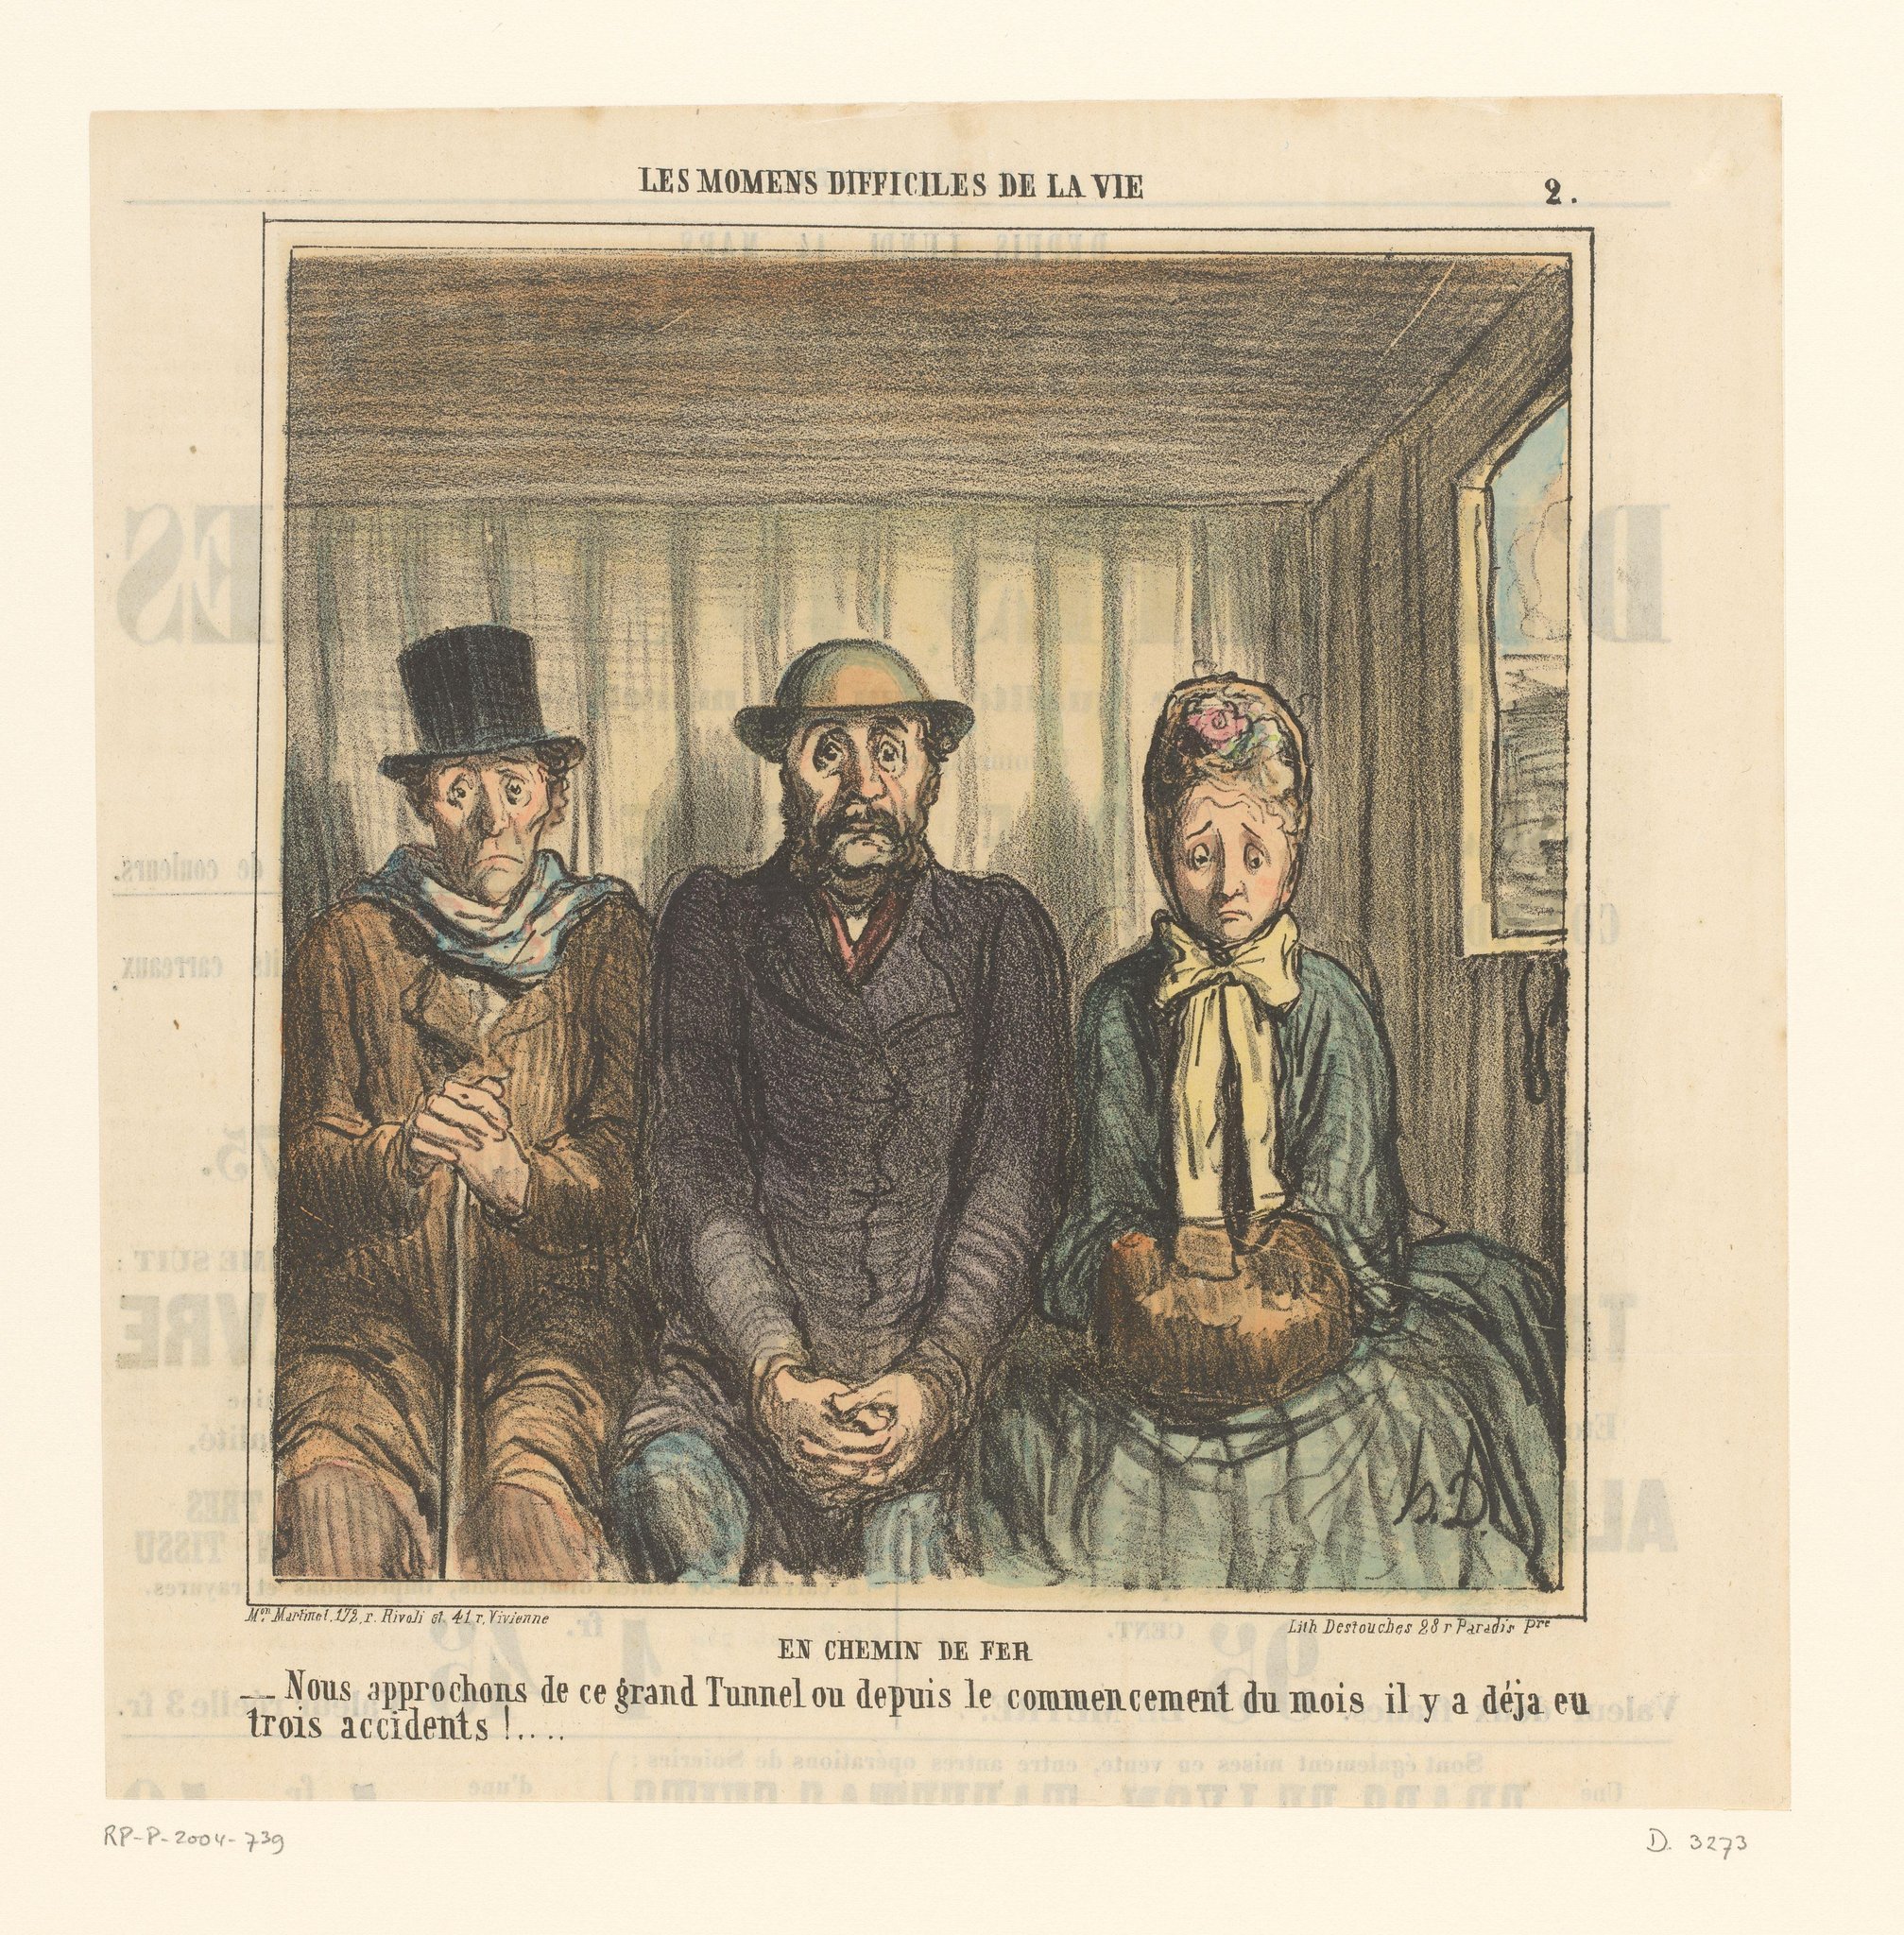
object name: print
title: Moeilijke momenten van het leven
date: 1864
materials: paper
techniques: hand coloring, letterpress printing, lithograph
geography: paris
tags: passenger train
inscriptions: collector's mark: Lugt 2228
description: Prent uit: Le Charivari 33 (1864), 16 maart 1864.